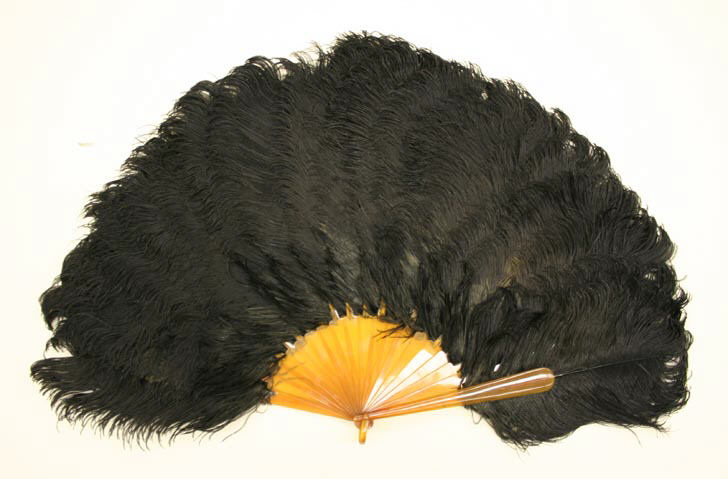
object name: fan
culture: american or european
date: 1867-1900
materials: feather, plastic